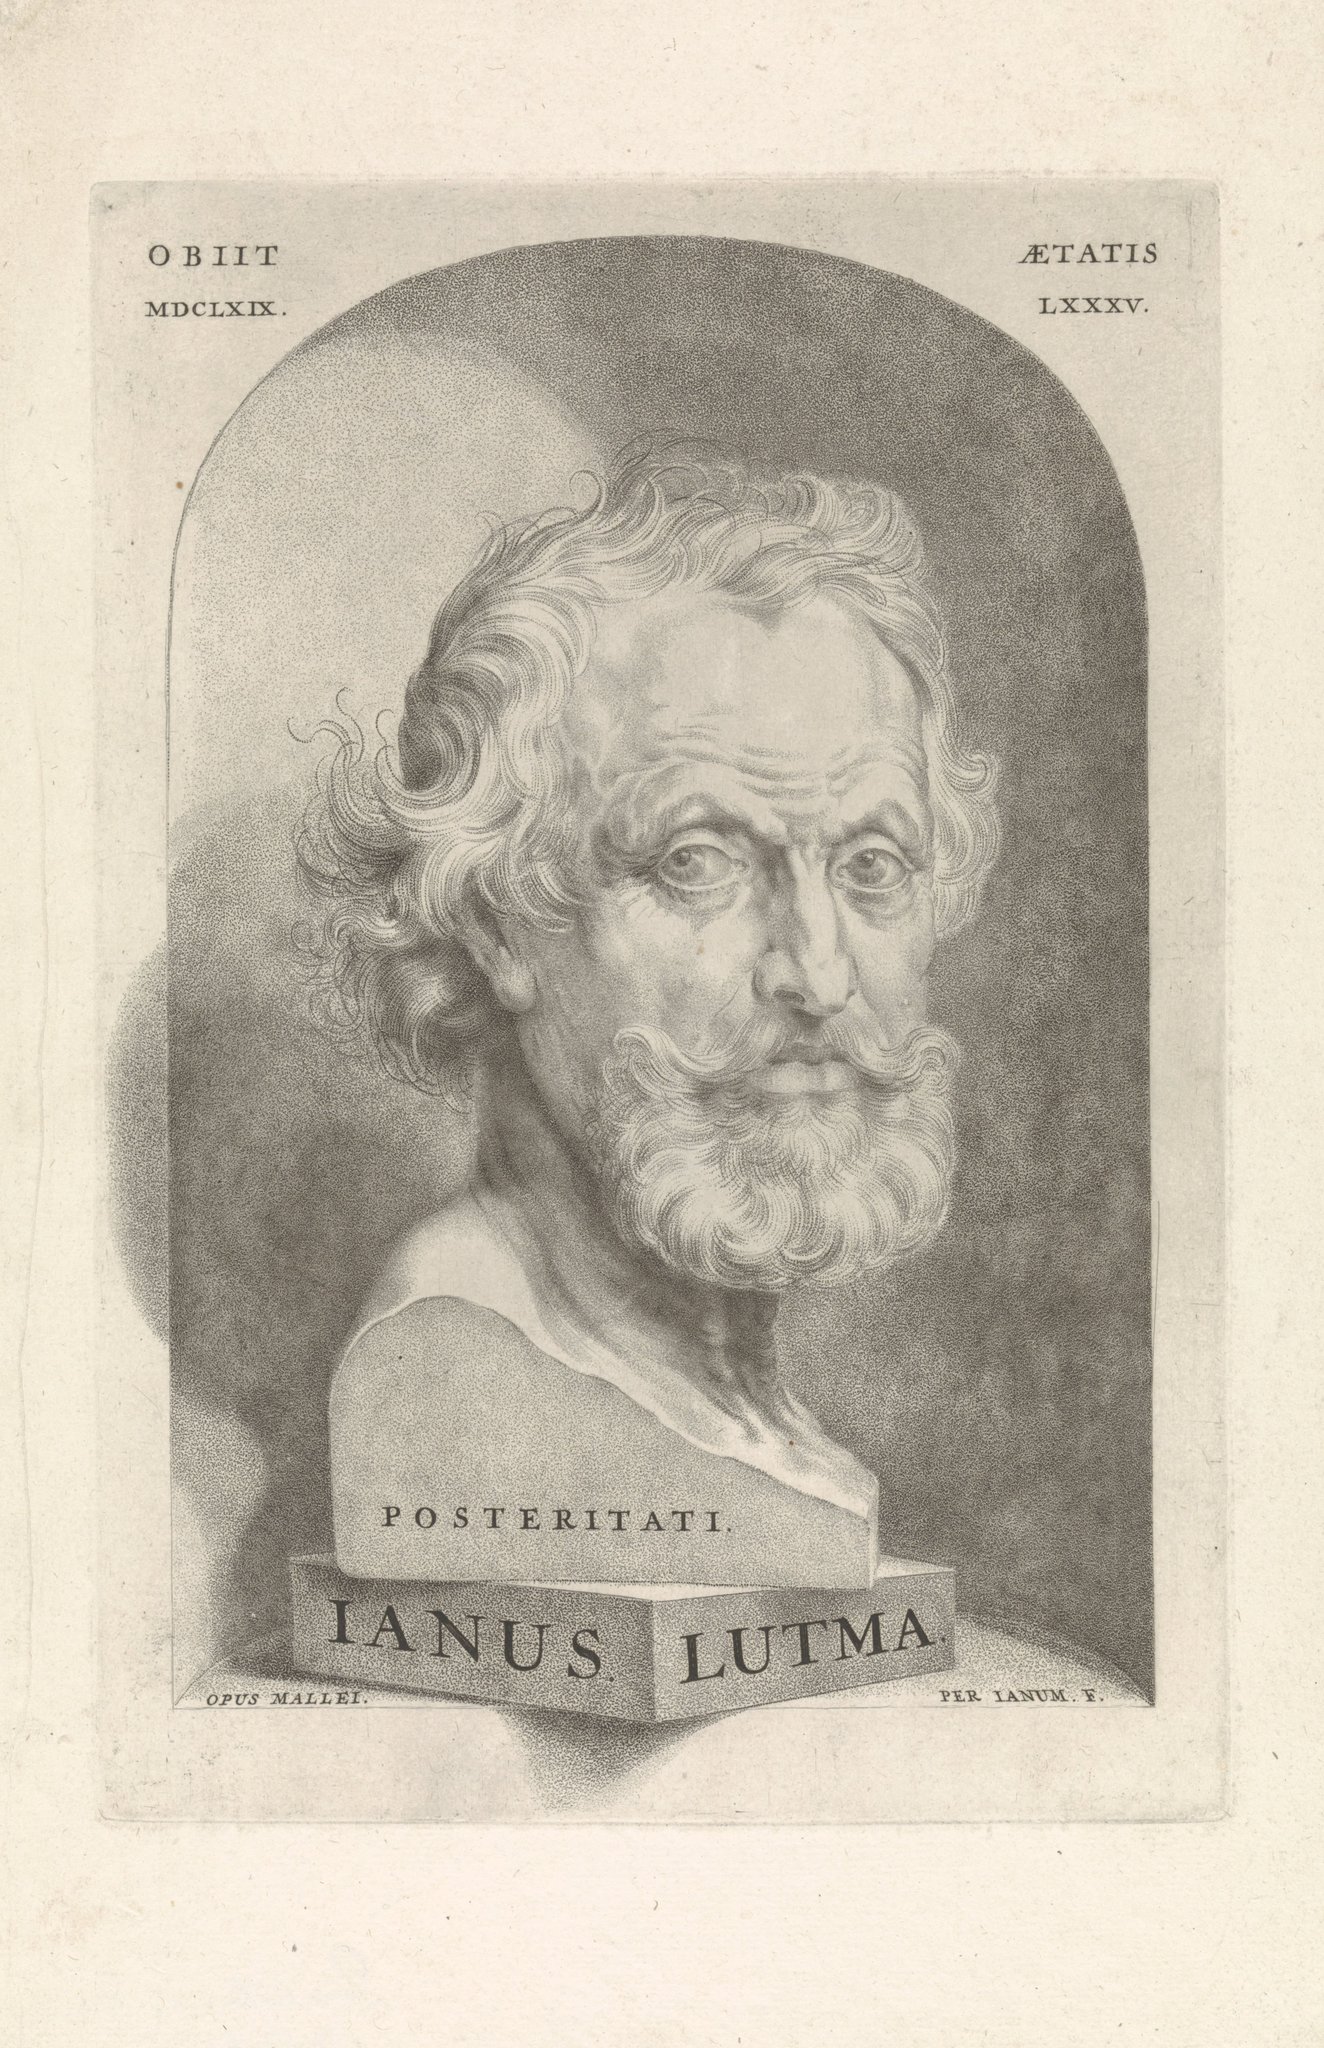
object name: print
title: Portretbuste van Johannes Lutma de Oude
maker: johannes lutma (1624-1689)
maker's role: print maker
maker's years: 1624-1689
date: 1634-1689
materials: paper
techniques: engraving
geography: amsterdam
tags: johannes lutma (1584-1669), piece of sculpture, reproduction of a piece of sculpture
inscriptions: collector's mark: Lugt 2228, collector's mark: Lugt 2760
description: Portretbuste van Johannes Lutma de Oude, op 85-jarige leeftijd.